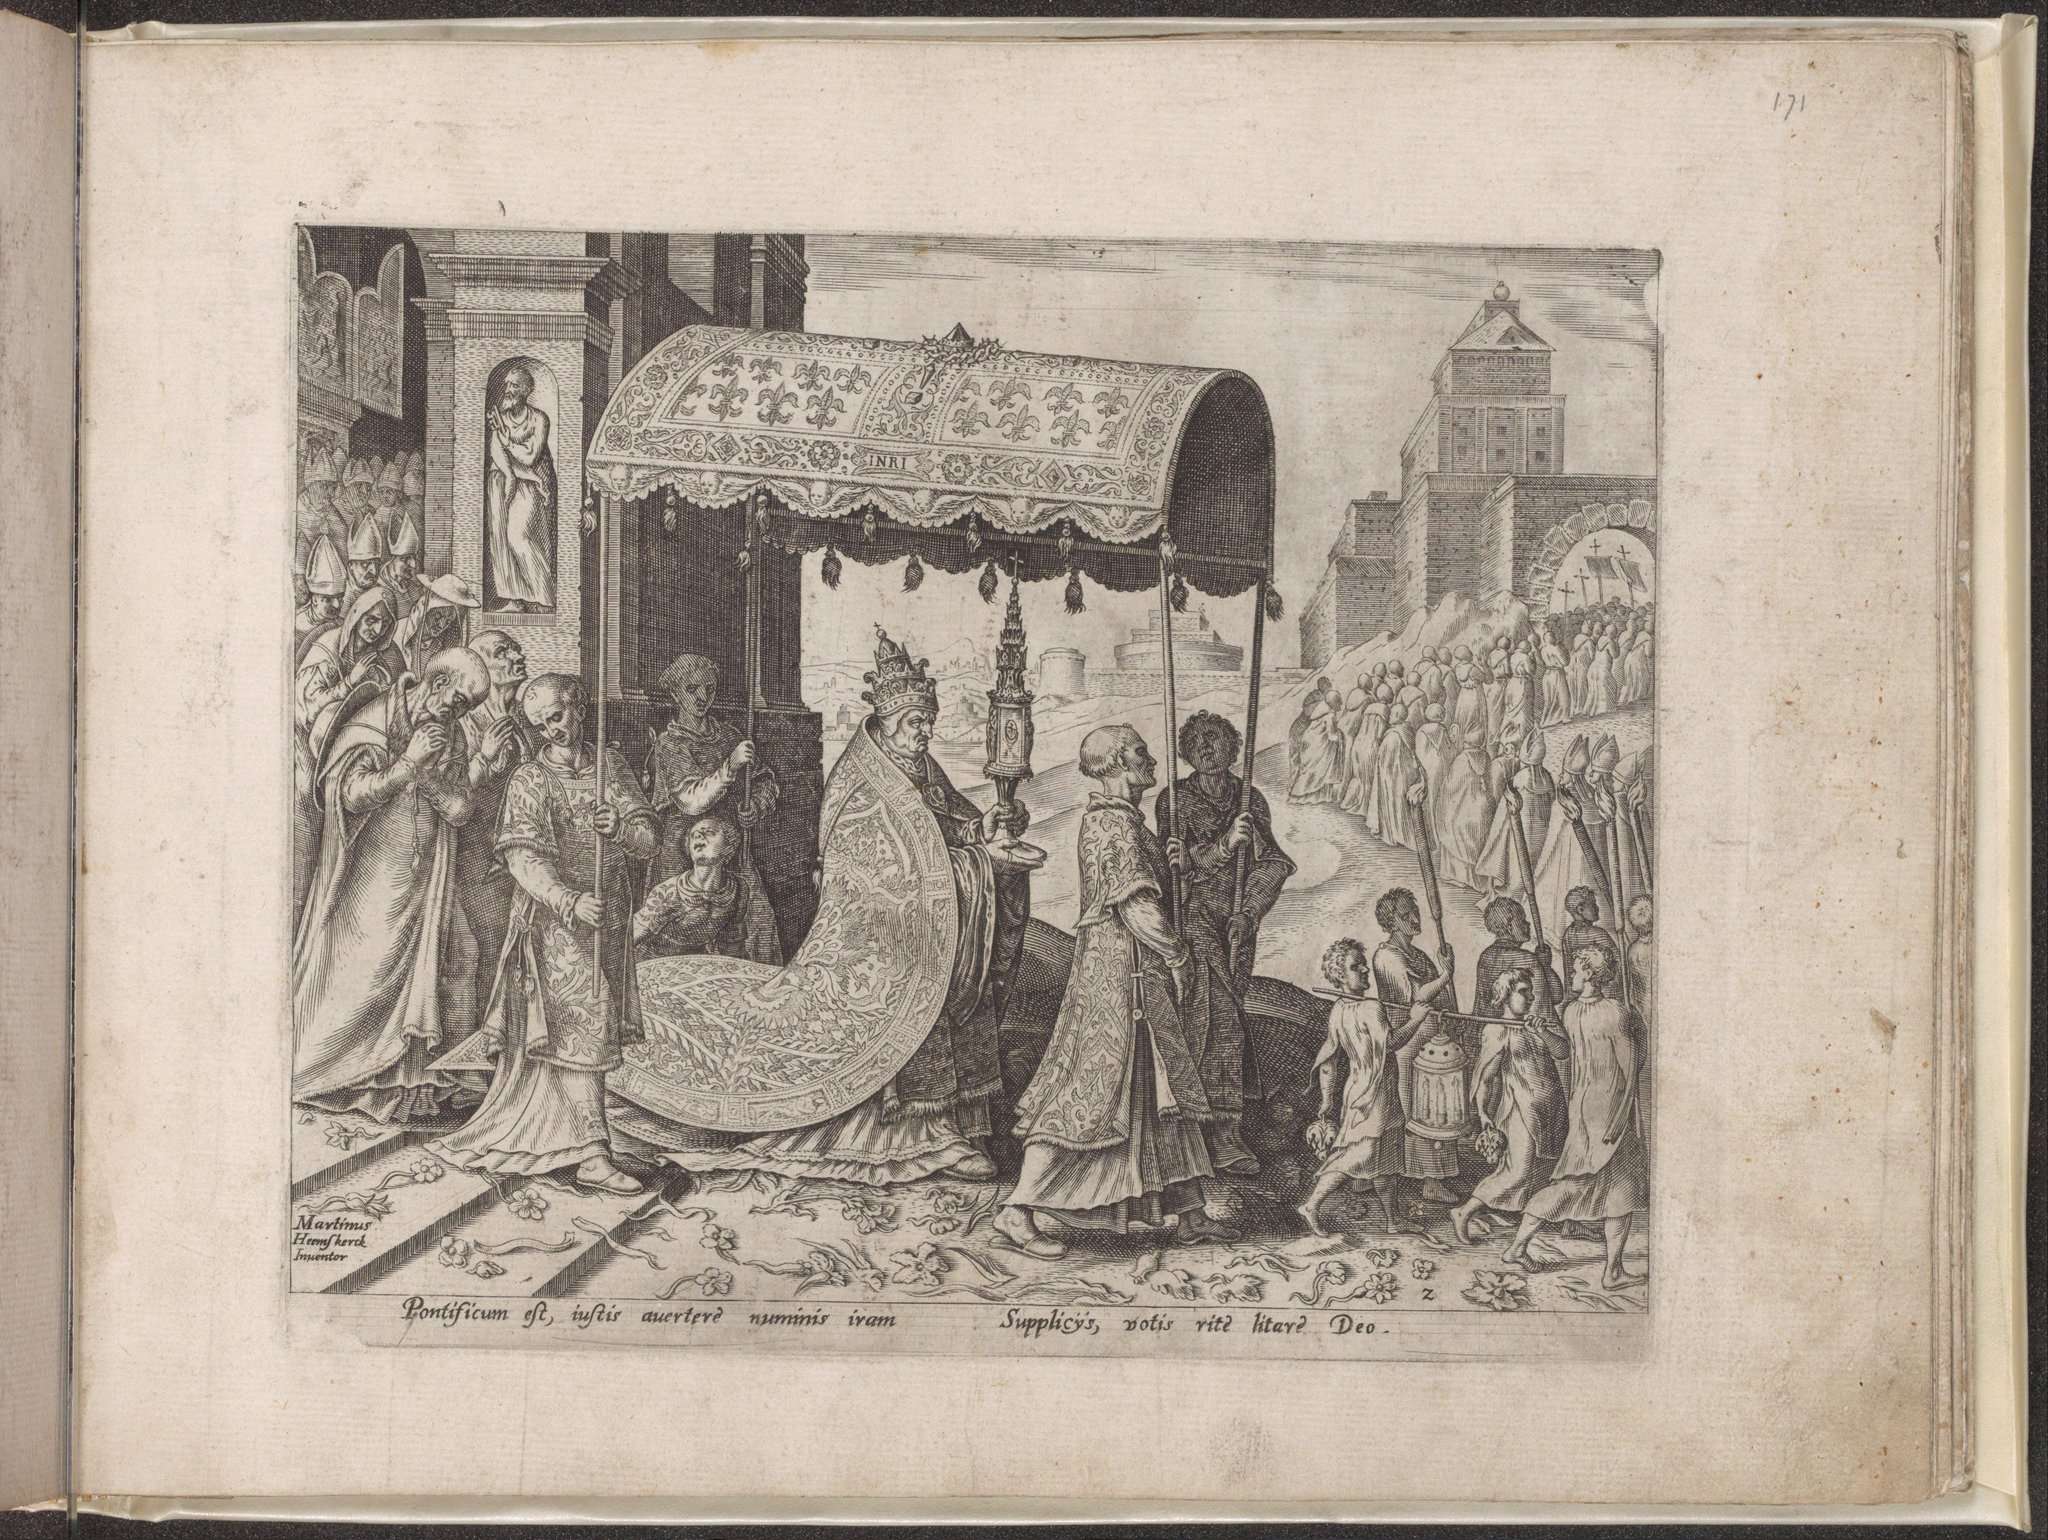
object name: album leaf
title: Uitvoering van de taak van de geestelijke stand door de paus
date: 1563-1570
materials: paper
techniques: engraving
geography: haarlem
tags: ceremonial procession, parade, pageant ~ pope, chalice bearing the host, organization, functionaries and dignitaries in roman catholic church; clergy in general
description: De paus wandelt mee in een processie van geestelijken. In zijn handen de kelk met de Heilige Hostie. Het is de taak van de geestelijke stand om te bidden voor het zielenheil van ieder individu in de gemeenschap. Onder de voorstelling een verklarende tekst in het Latijn. Deze prent maakt deel uit van een album.